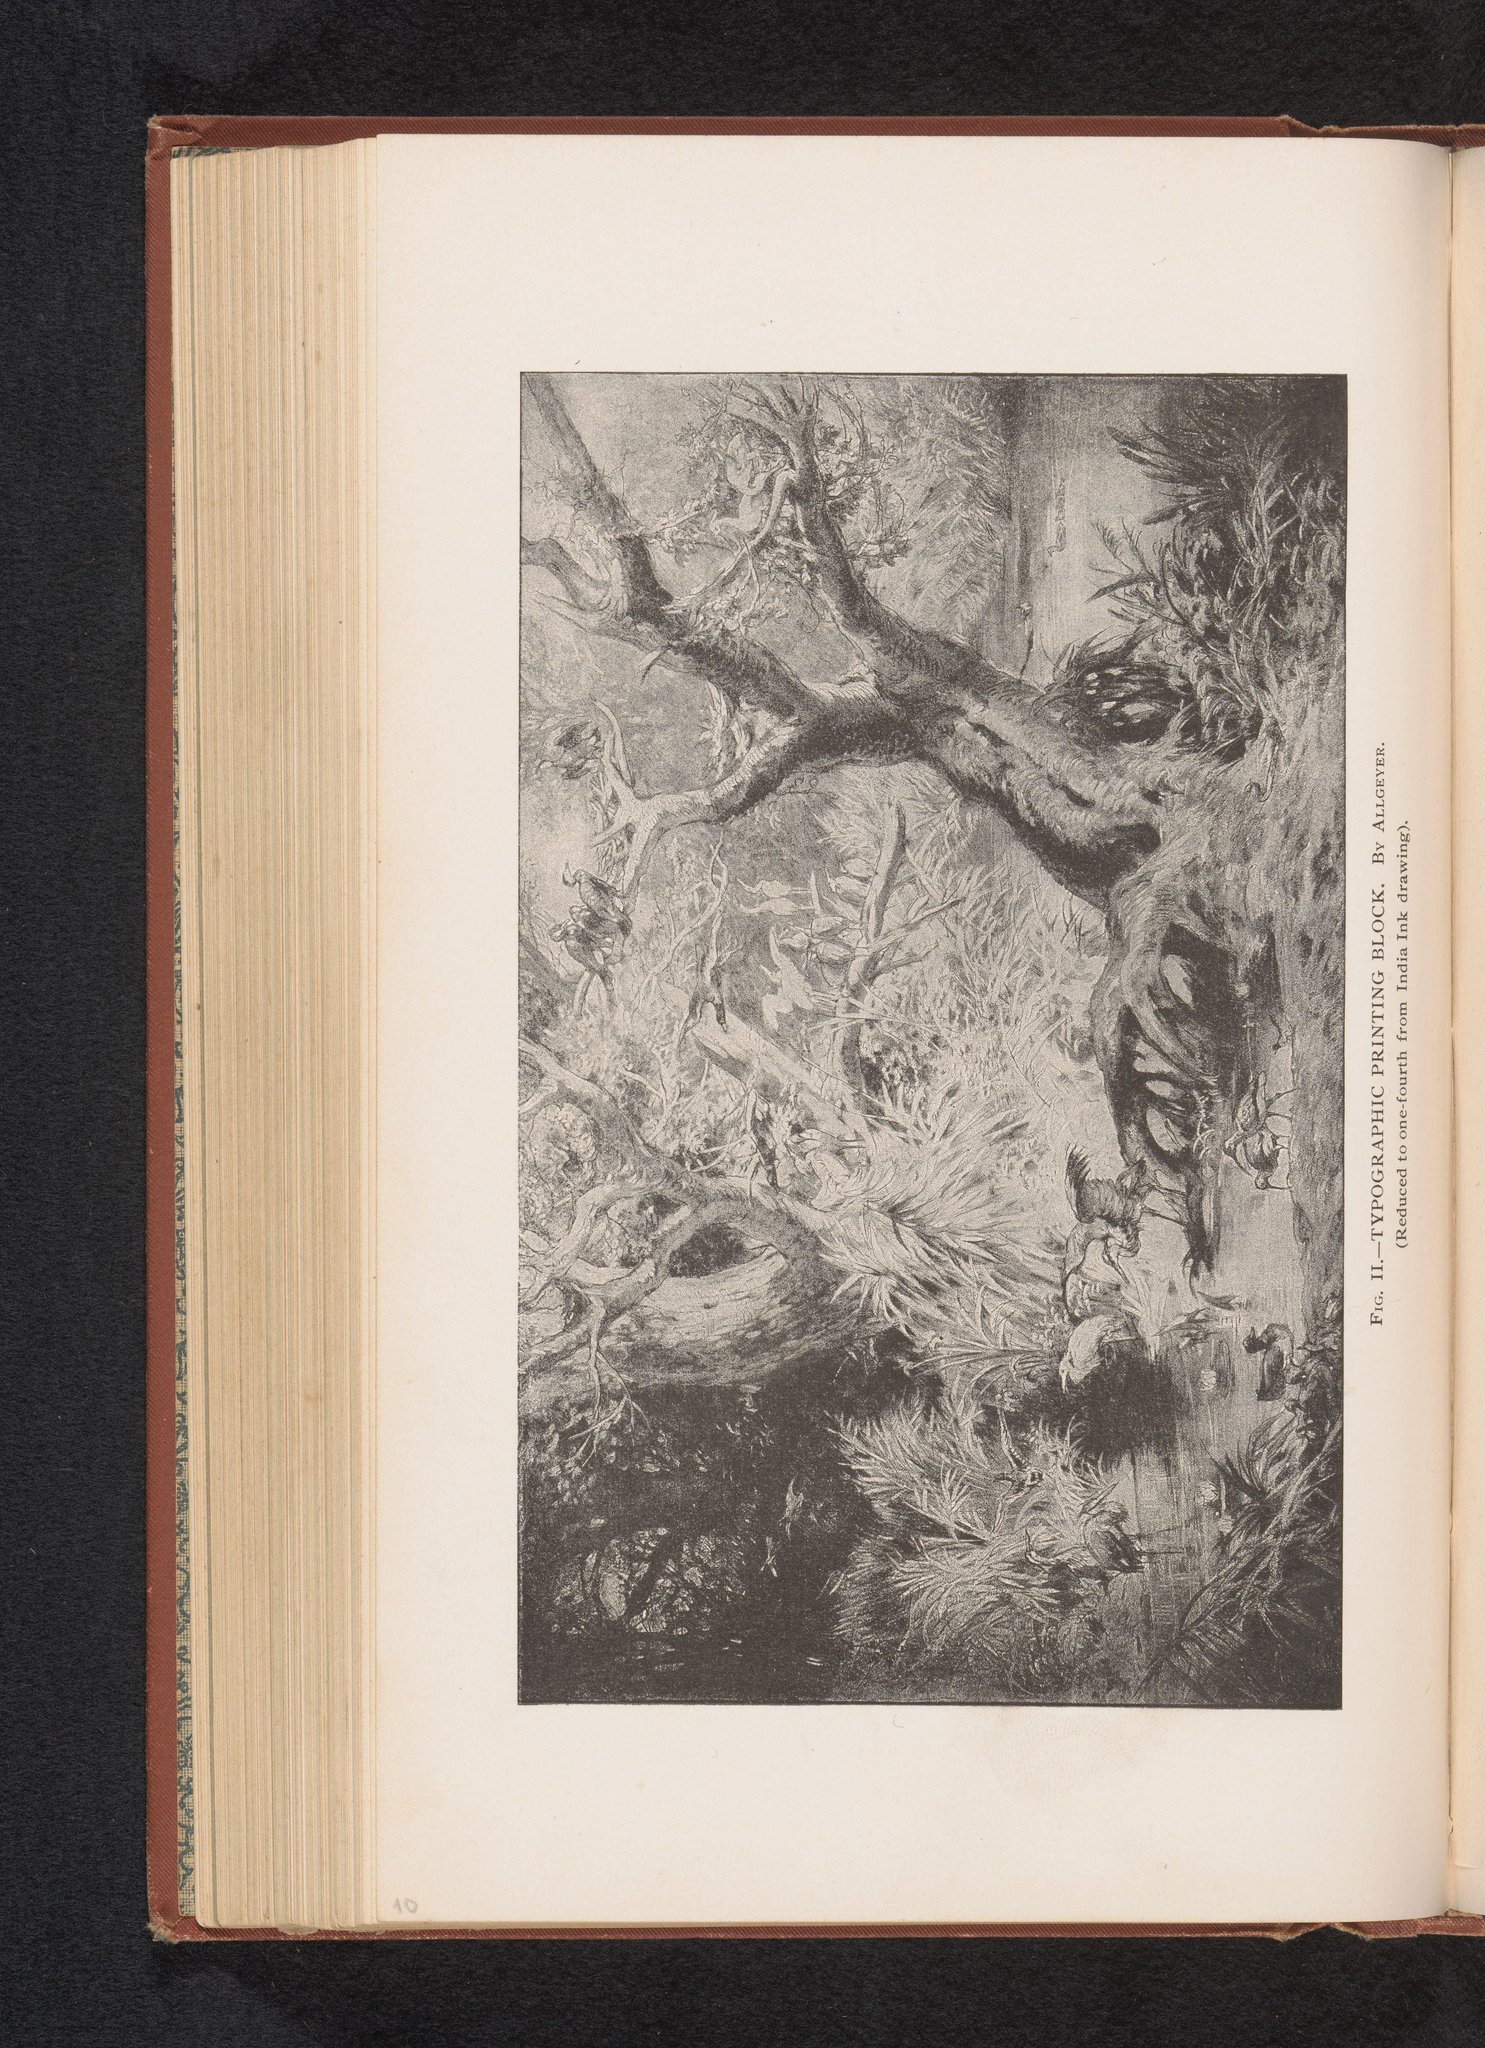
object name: page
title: Reproductie van een tekening van vogels bij een waterpartij in een bos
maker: julius allgeyer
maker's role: print maker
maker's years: 1829-1900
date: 1884-1889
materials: paper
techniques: photochemical processes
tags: birds, forest, wood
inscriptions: inscription: ‘(Reduced to one-fourth from India Ink drawing).’, inscription: ‘Fig. II. - Typographic Printing Block’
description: Prent op tweede ongenummerde pagina na pagina 192.